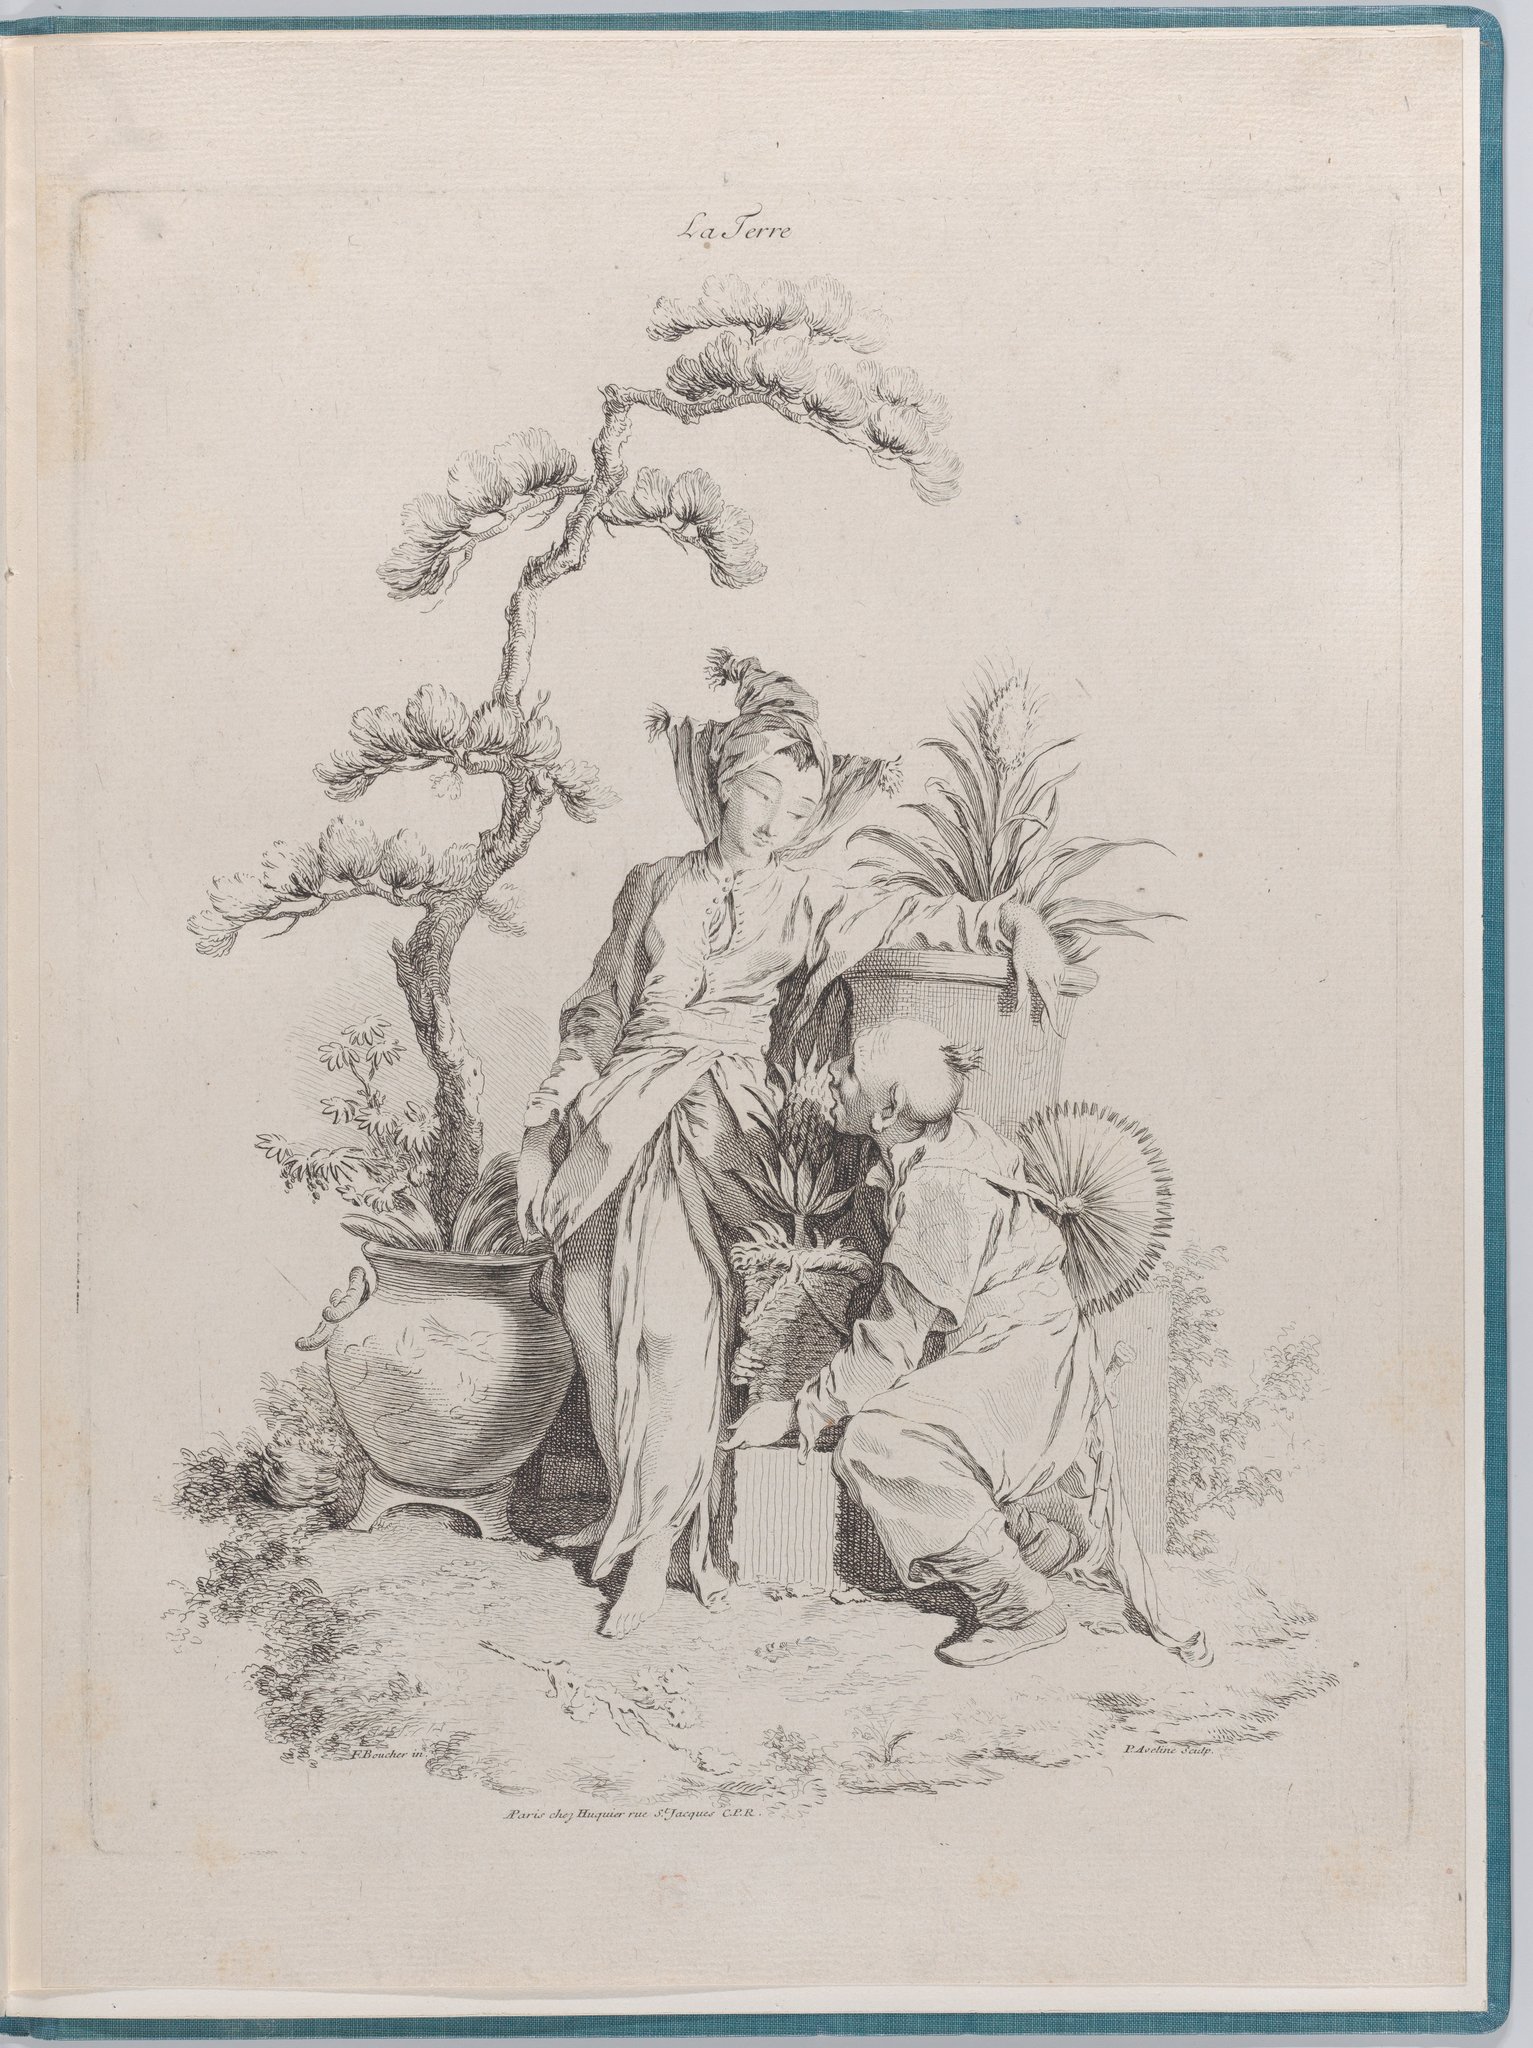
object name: print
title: Earth, from The Four Elements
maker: pierre alexandre aveline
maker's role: artist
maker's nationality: french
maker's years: 1702-1760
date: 1738-1749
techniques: engraving, etching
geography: france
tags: chinoiserie,men,women